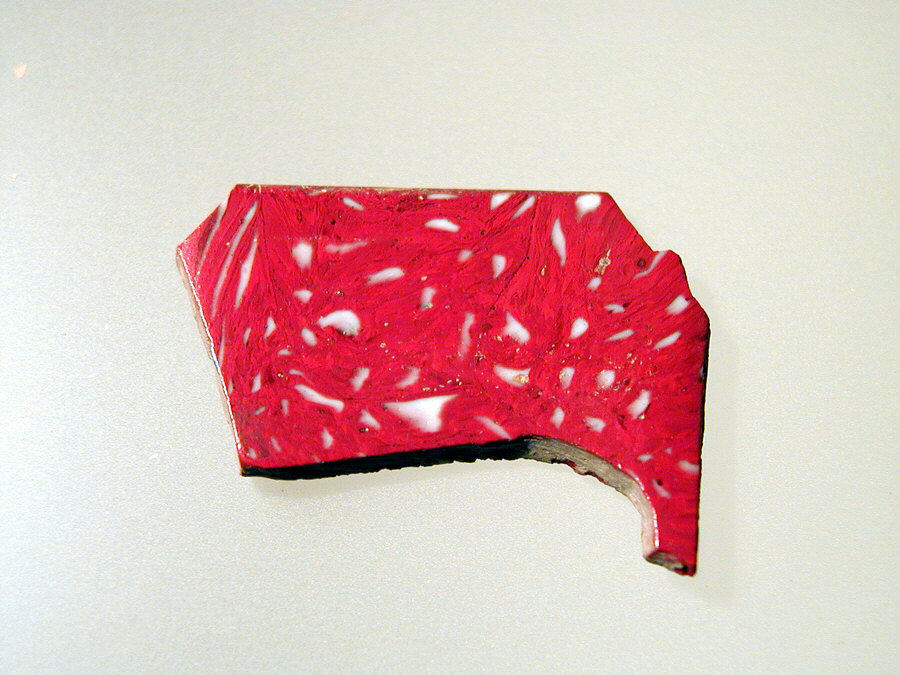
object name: fragment, mosaic bowl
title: Mosaic glass bowl fragment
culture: roman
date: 34 BCE-33 CE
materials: glass